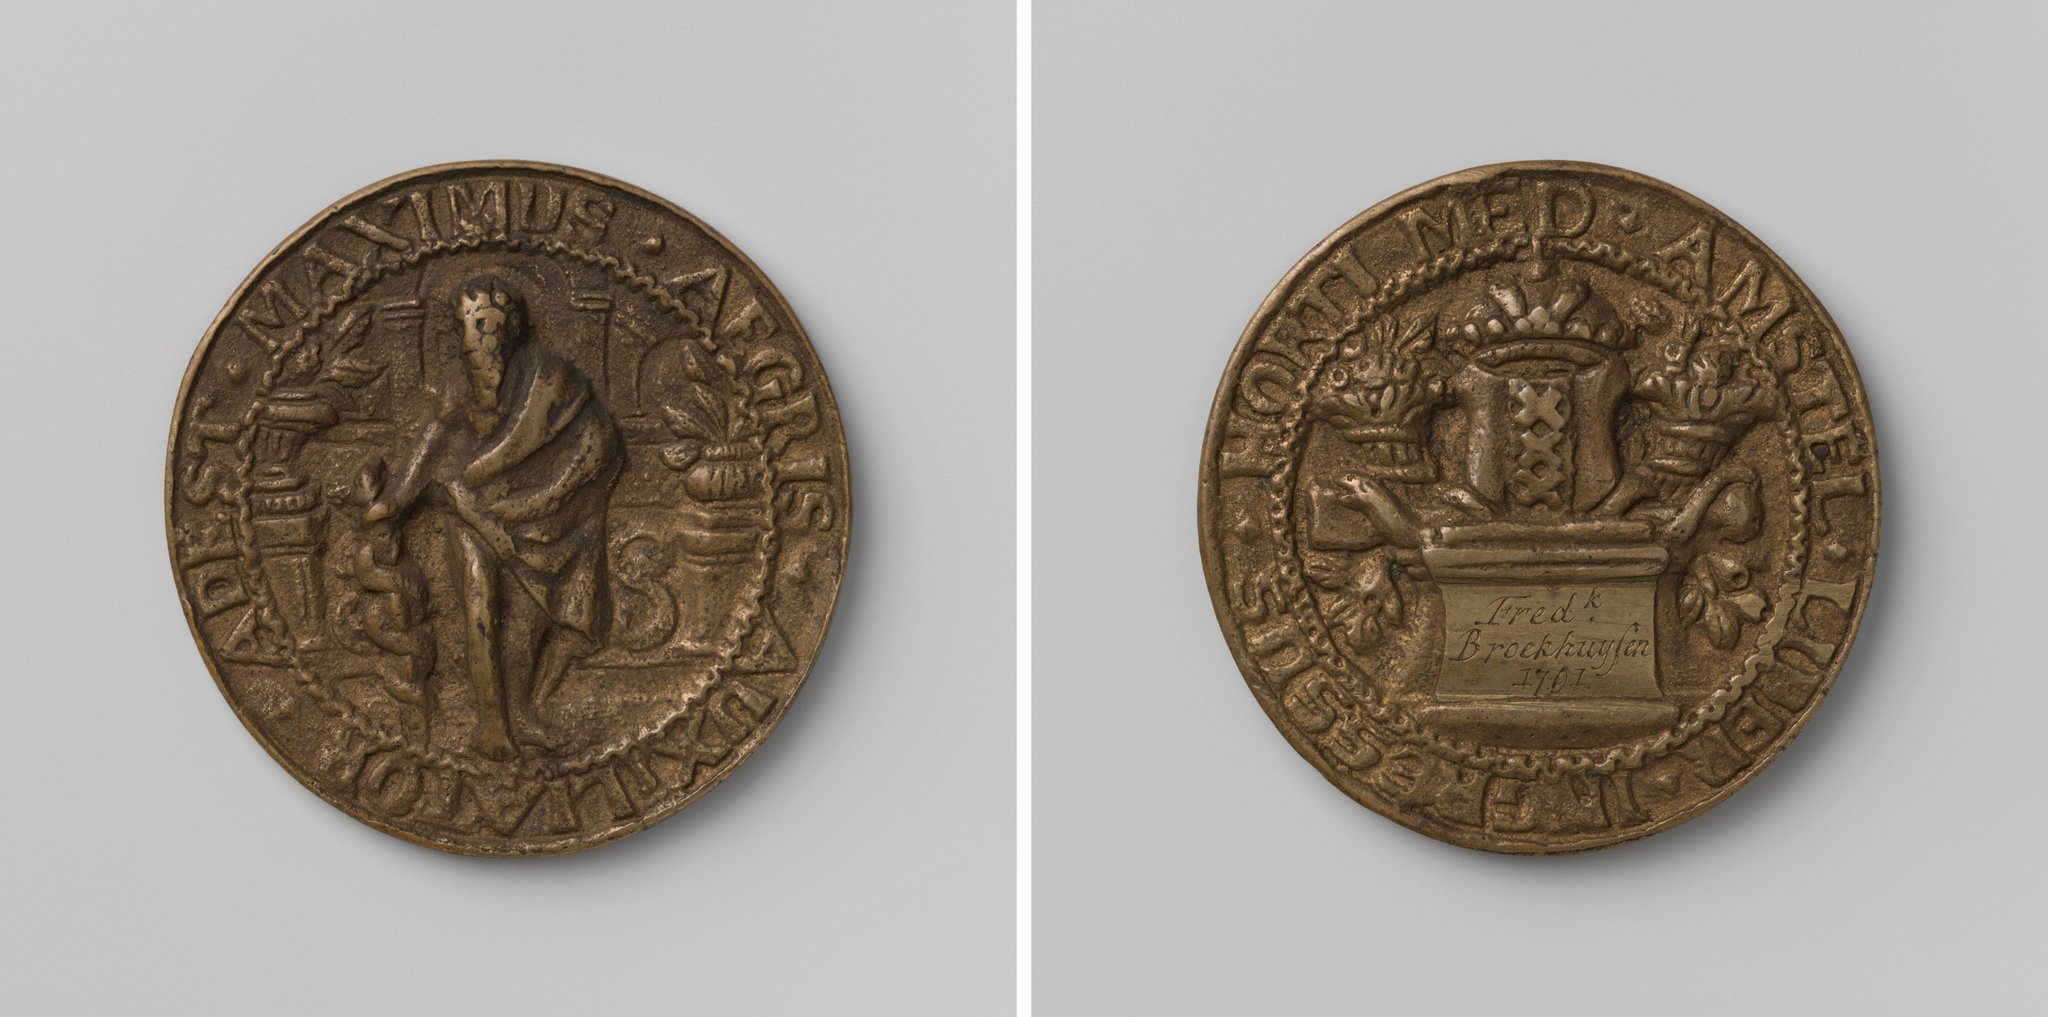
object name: medal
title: Collegium Medicum te Amsterdam, toegangspenning voor de hortus medicus van Frederik Broekhuijsen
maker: willem de wijs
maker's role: medailleur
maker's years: 1700-1795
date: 1791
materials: brass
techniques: casting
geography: amsterdam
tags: amsterdam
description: Messing penning. Voorzijde: Aesculapius met rechterhand leunend op slangestaf en linkerhand onder zijn mantel, staande tussen twee vazen met planten op voetstuk; op achtergrond wand van gebouw binnen omschrift. Keerzijde: gekroond wapenschild tussen twee gevulde hoorns van overvloed boven zalfspatel, waarom slang zich kronkelt, liggend op voetstuk binnen omschrift